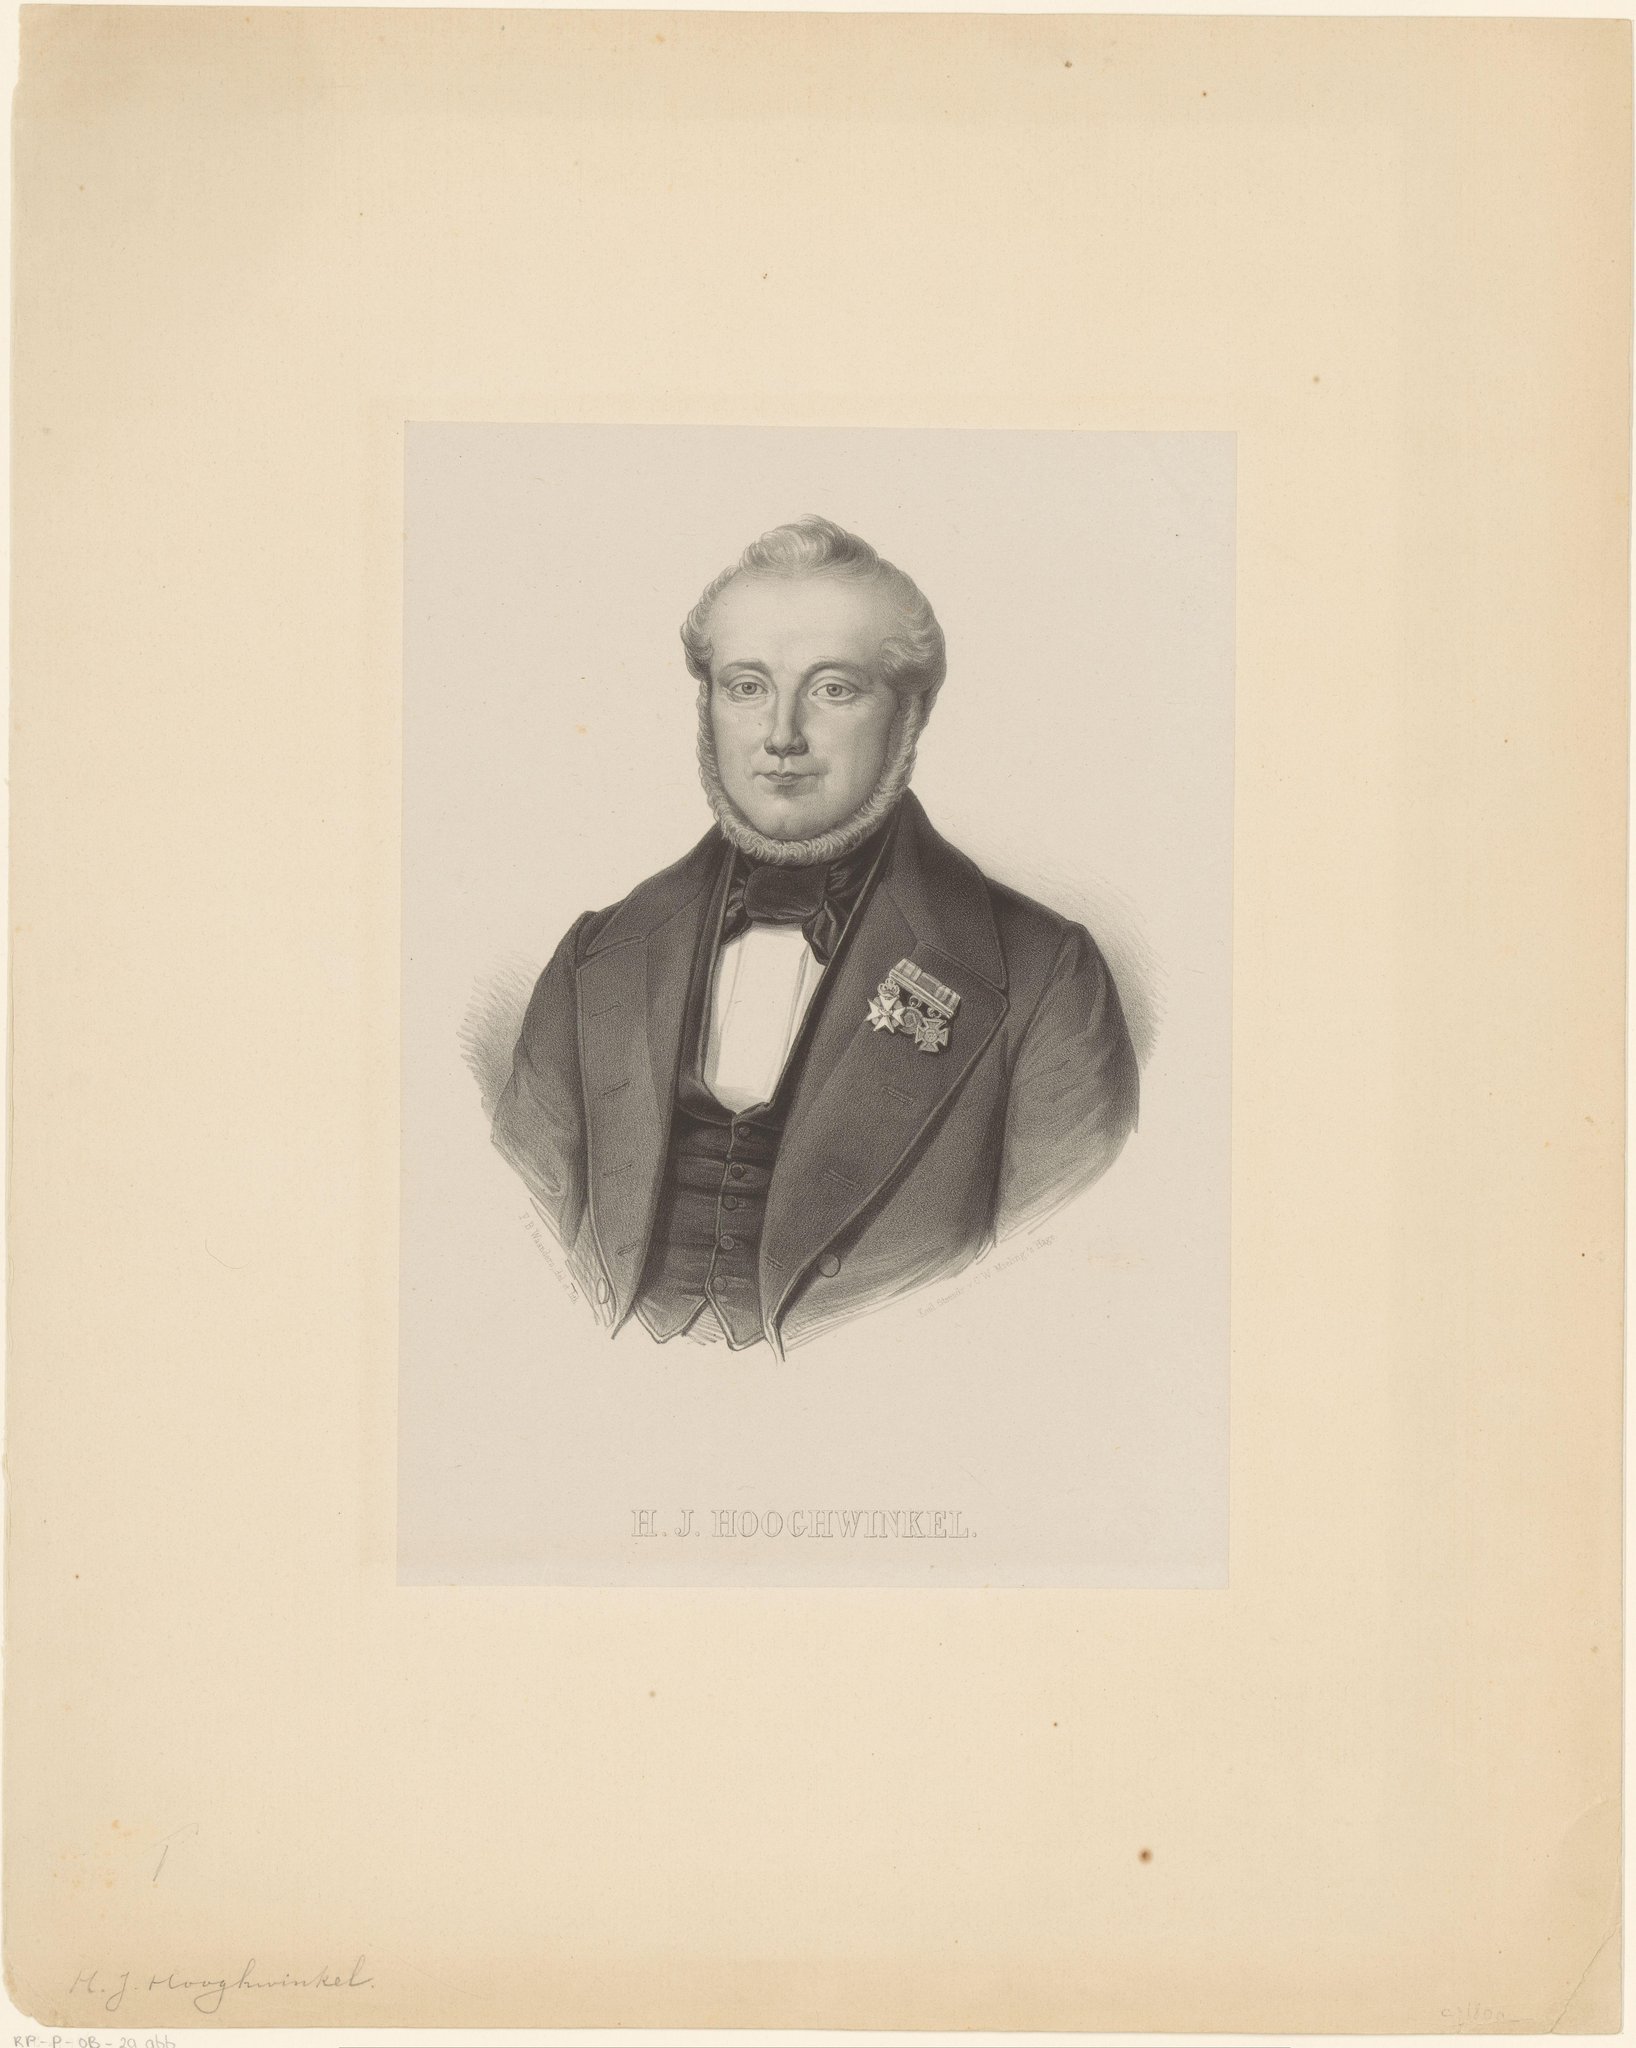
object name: print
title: Portret van H.J. Hooghwinkel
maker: franciscus bernardus waanders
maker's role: print maker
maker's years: 1809-1880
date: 1847-1865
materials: paper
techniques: lithograph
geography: the hague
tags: historical persons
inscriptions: collector's mark: Lugt 2228